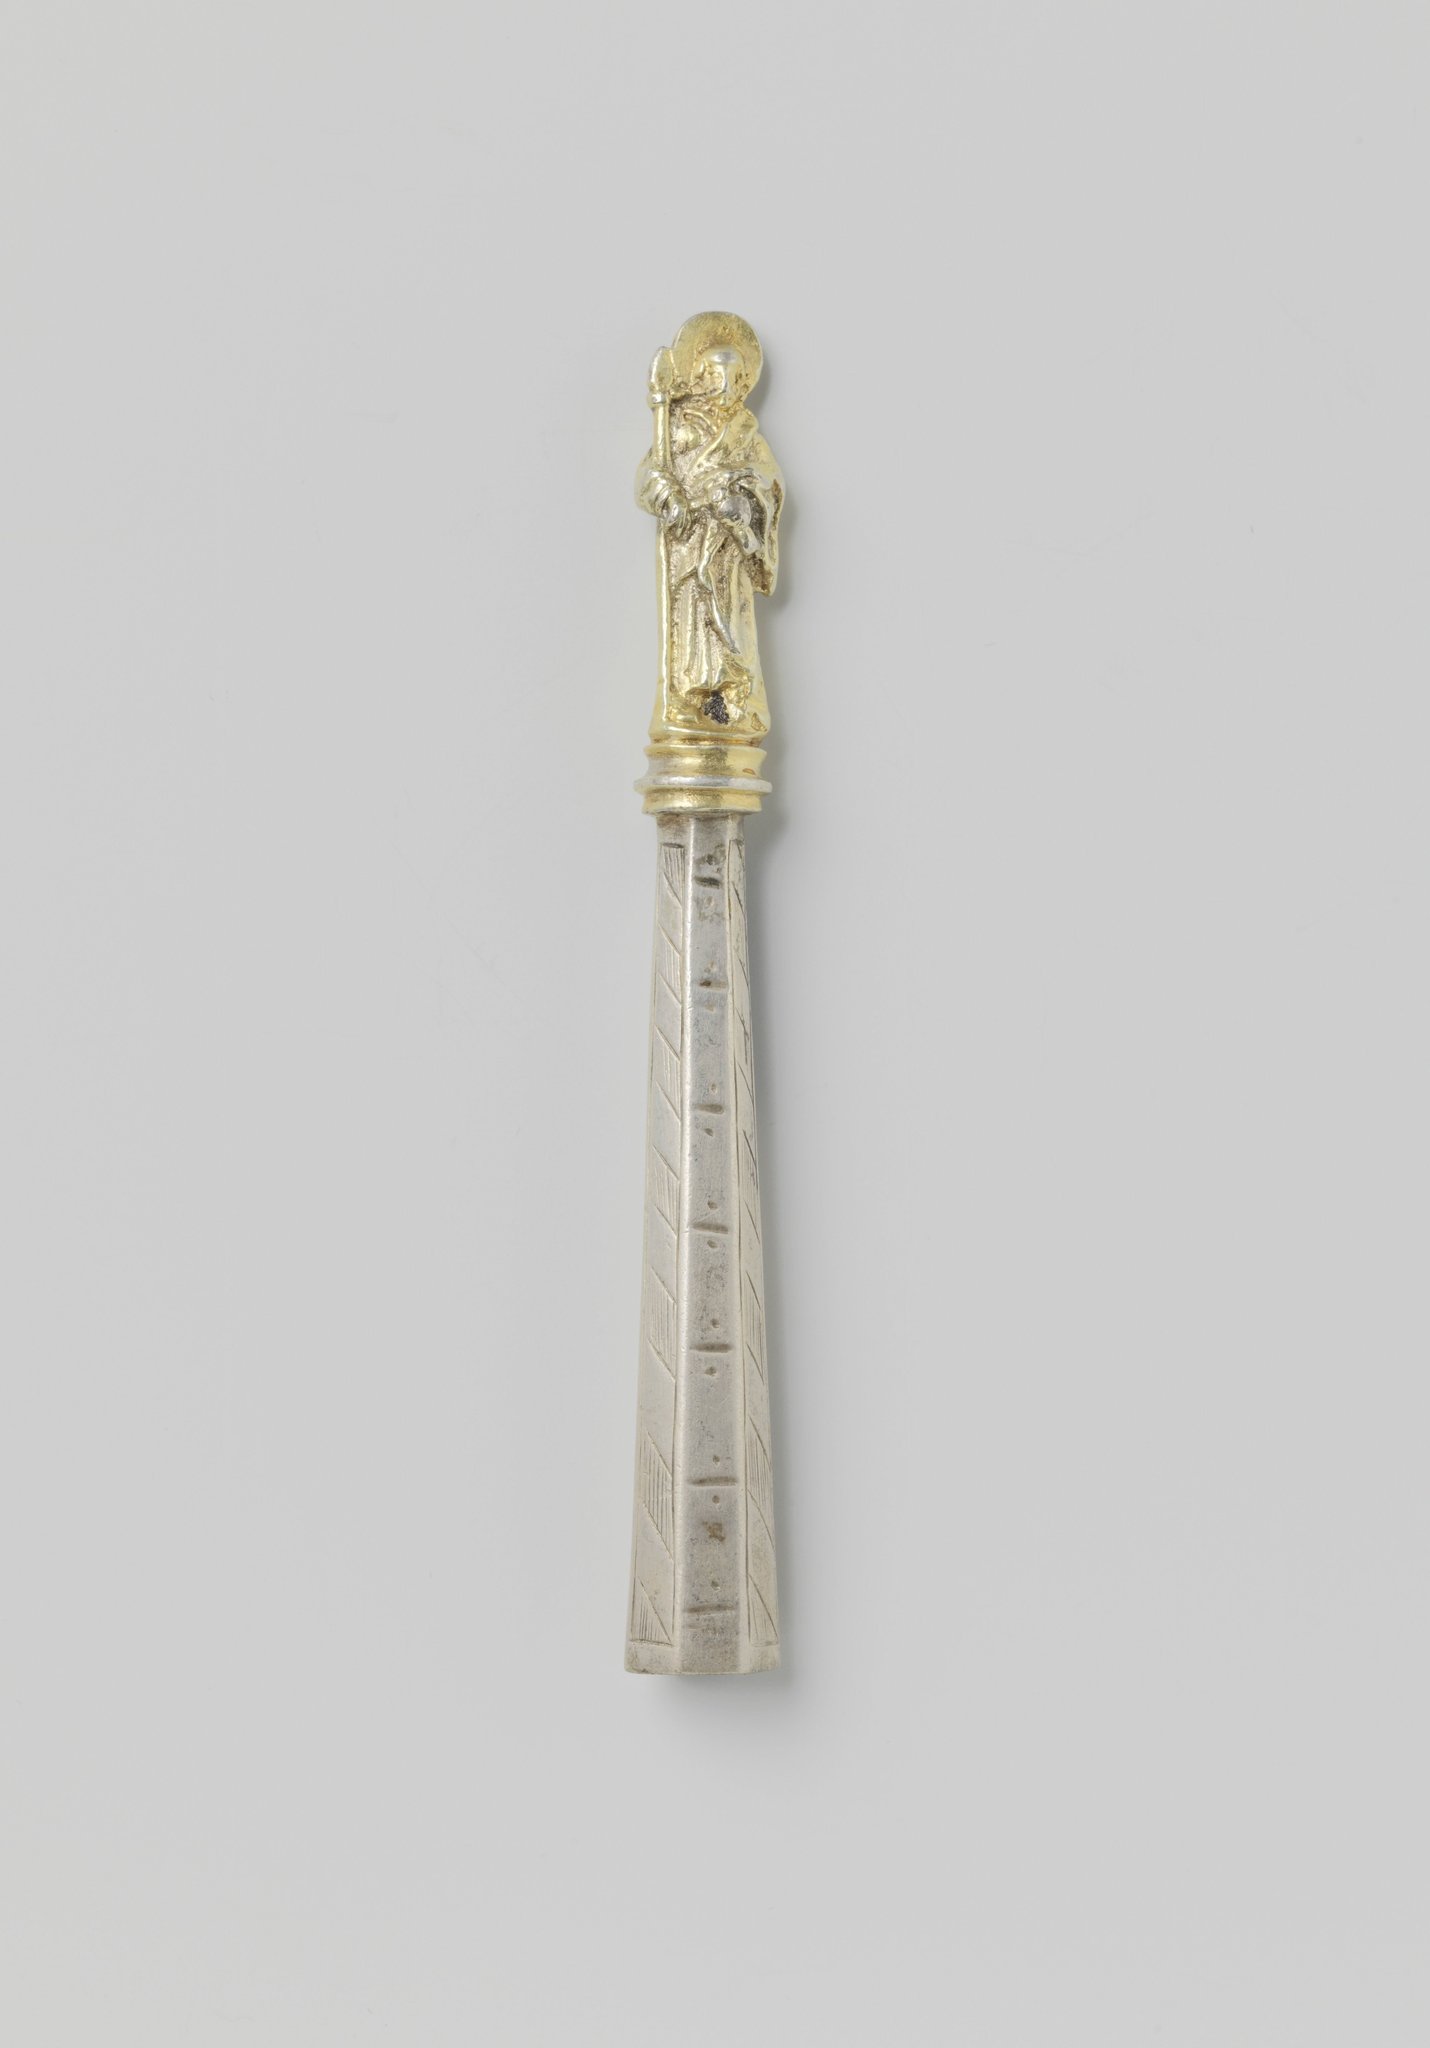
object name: lepelsteel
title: Lepelsteel van zilver eindigend in apostelfiguur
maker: Anonymous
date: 1600-1625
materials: silver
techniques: gilding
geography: germany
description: Lepelsteel van zilver met aan het uiteinde het vergulde beeld van een apostel